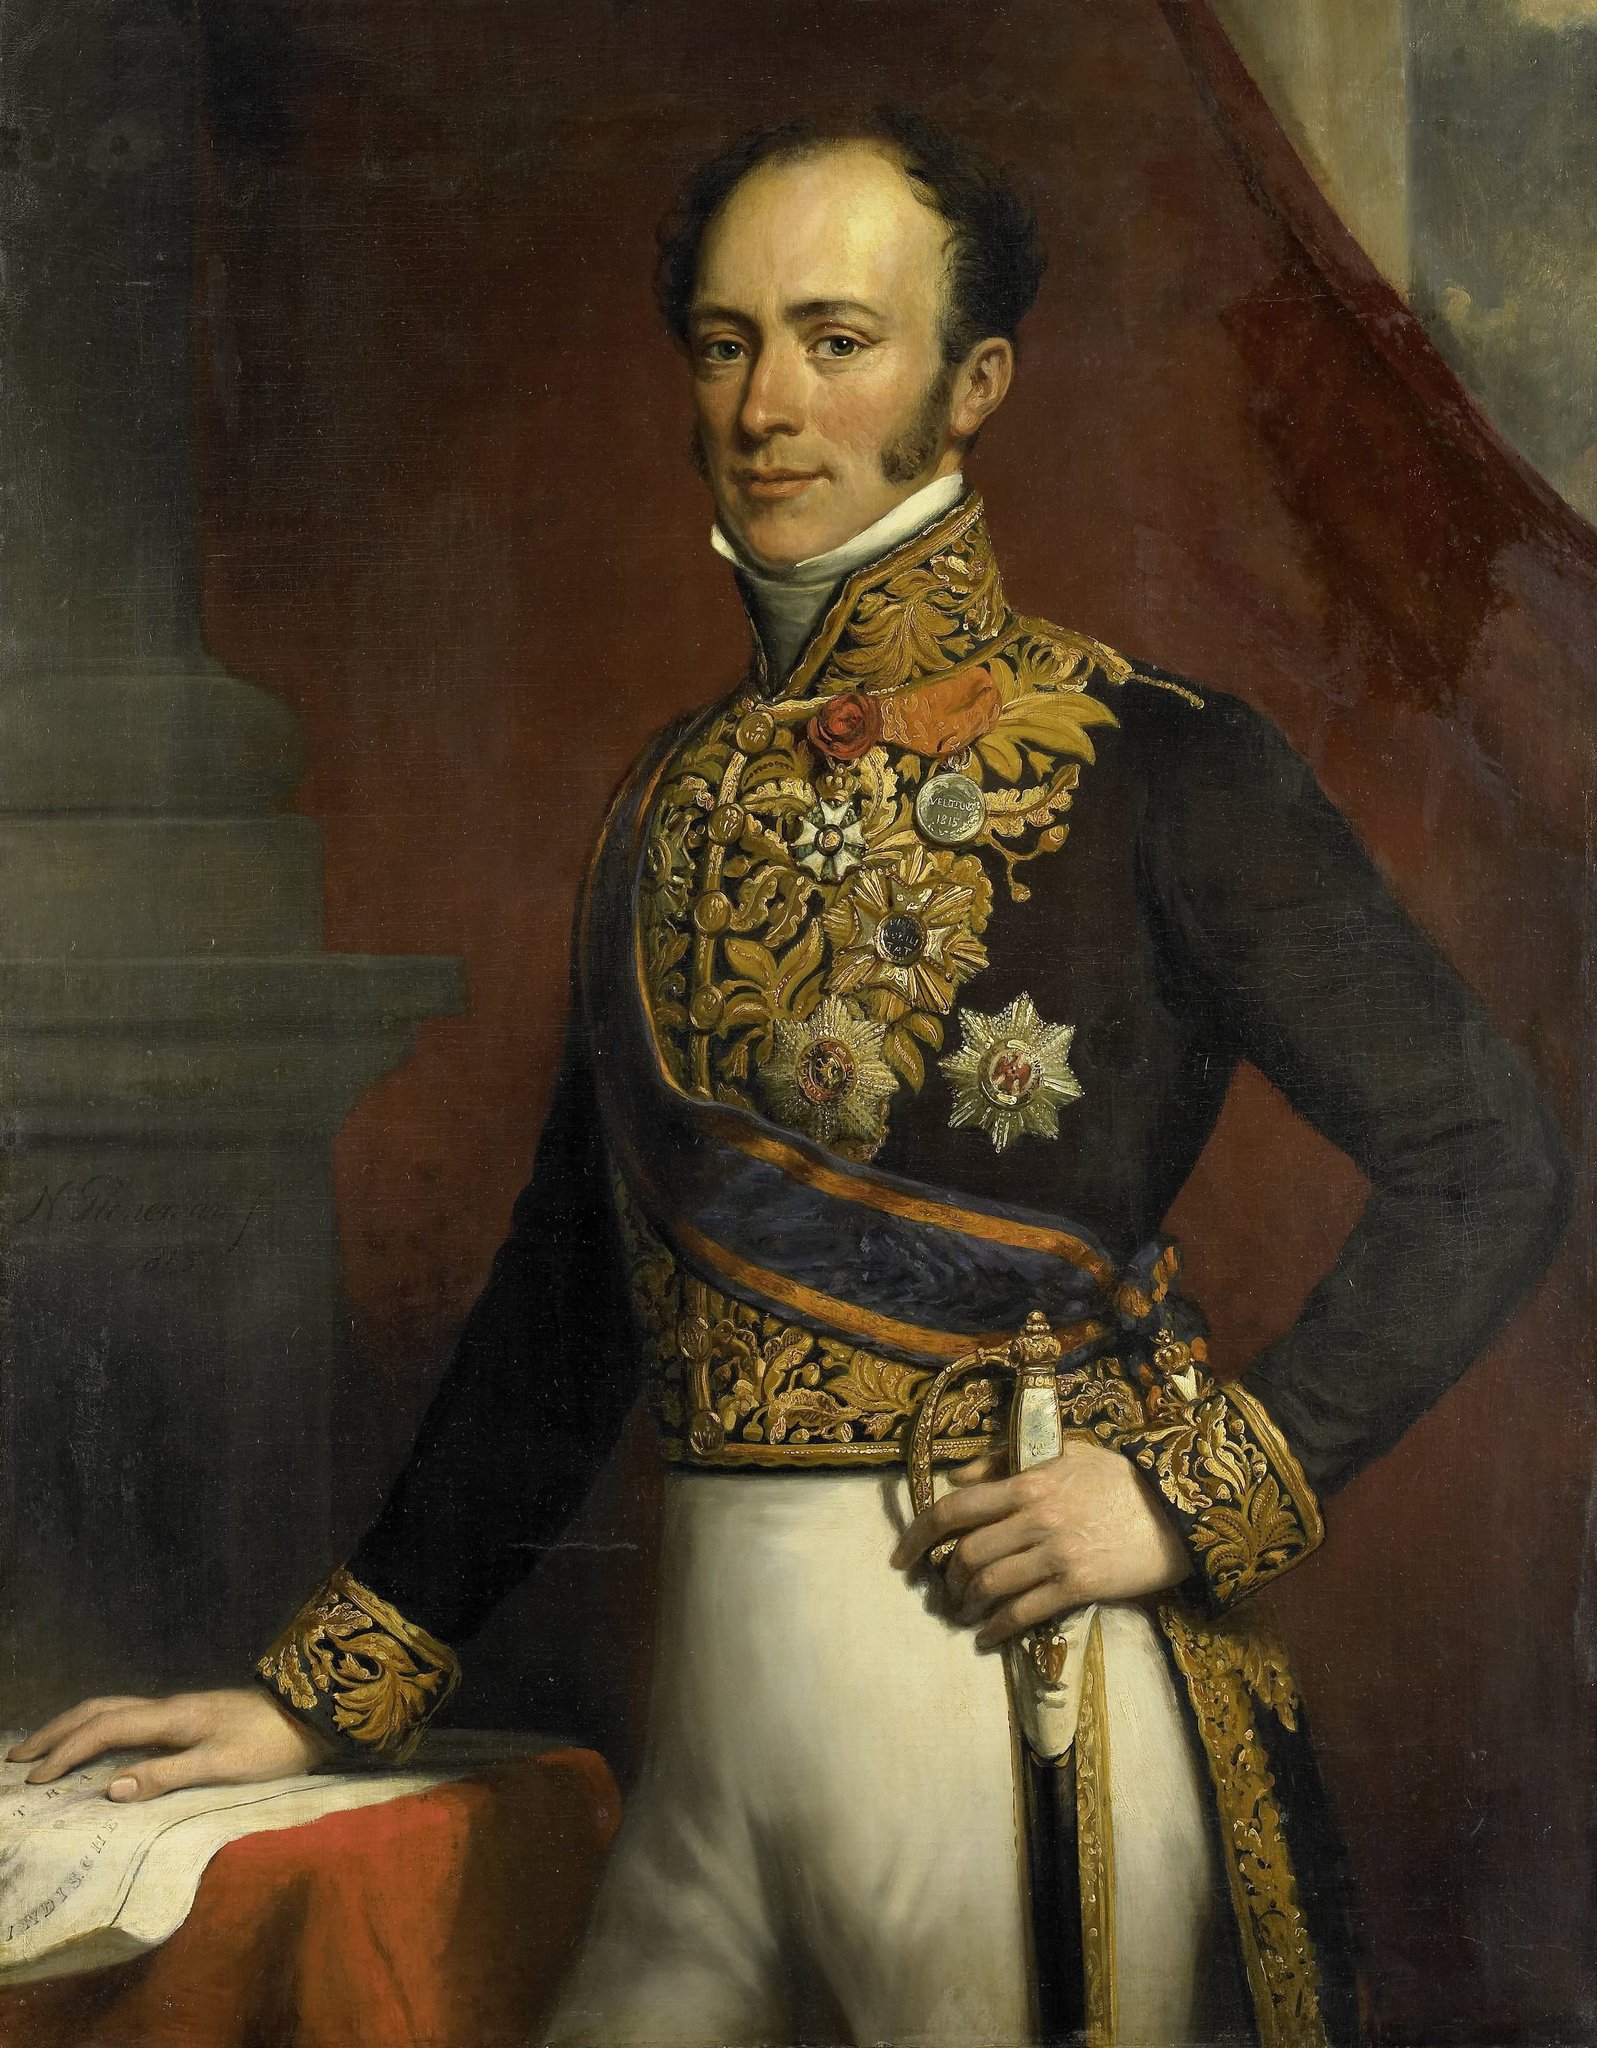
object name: painting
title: Portrait of Jan Jacob Rochussen, Governor-General of the Dutch East Indies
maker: nicolaas pieneman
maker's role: draughtsman, painter, print maker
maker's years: 1809-1860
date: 1845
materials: canvas, oil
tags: the hague, colonial governor, historical persons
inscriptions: signature and date: ‘N. Pieneman 1845’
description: Portret van Jan Jacob Rochussen (1797-1871). Gouverneur-generaal (1845-51). Kniestuk, staande naar links. De rechterhand rustend op een kaart van Indië op een tafel, de linkerhand op het gevest van zijn degen. Onderdeel van een reeks van portretten van de gouverneurs-generaal van het voormalige Nederlands Oost-Indië.